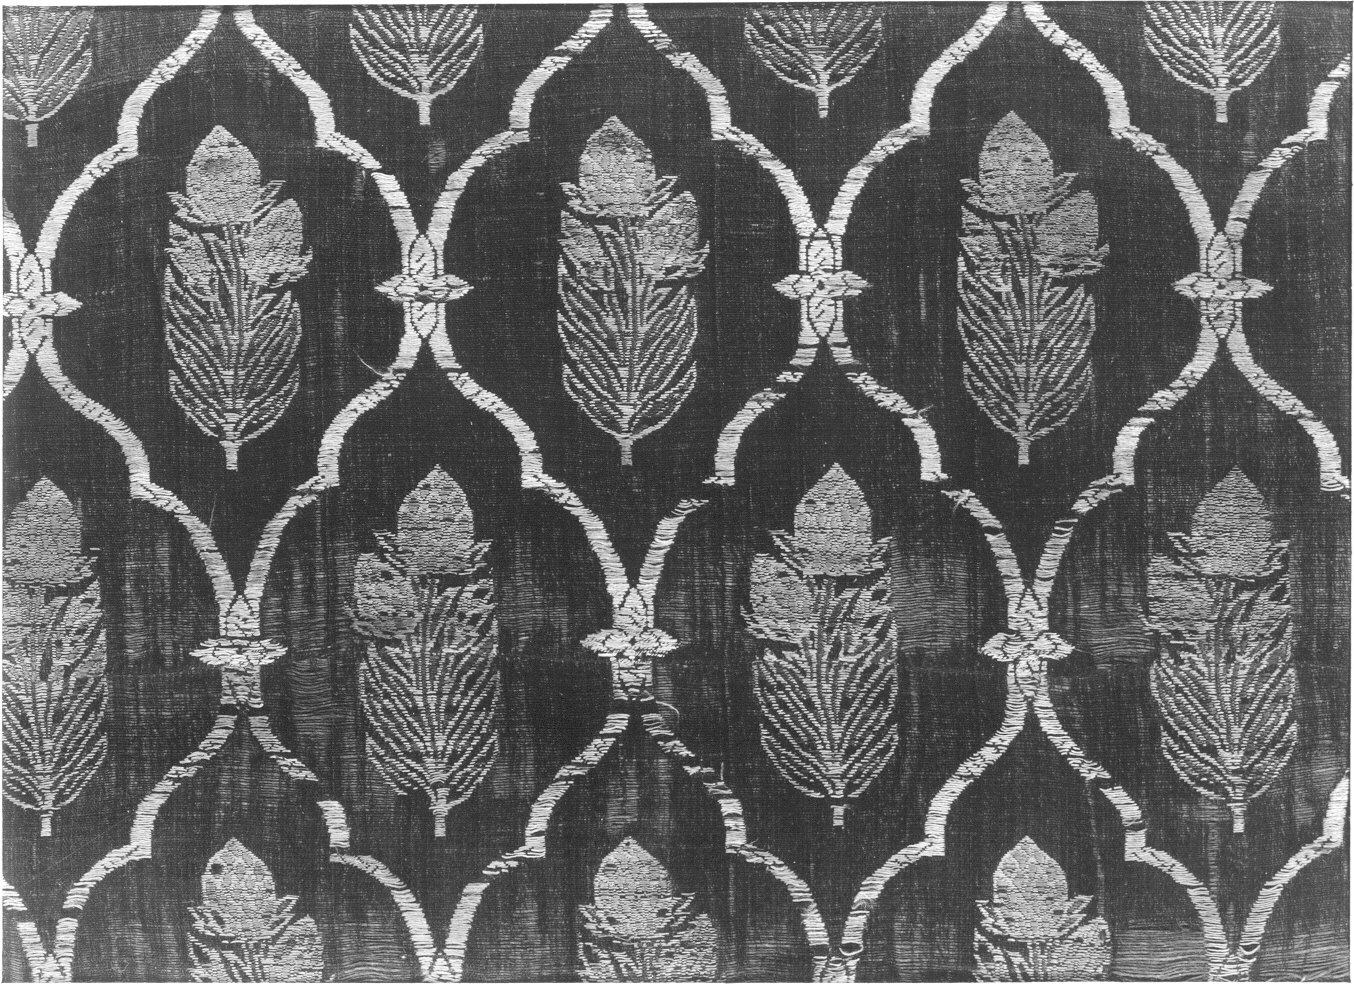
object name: textile fragment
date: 1601-1700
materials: metal thread, silk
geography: iran